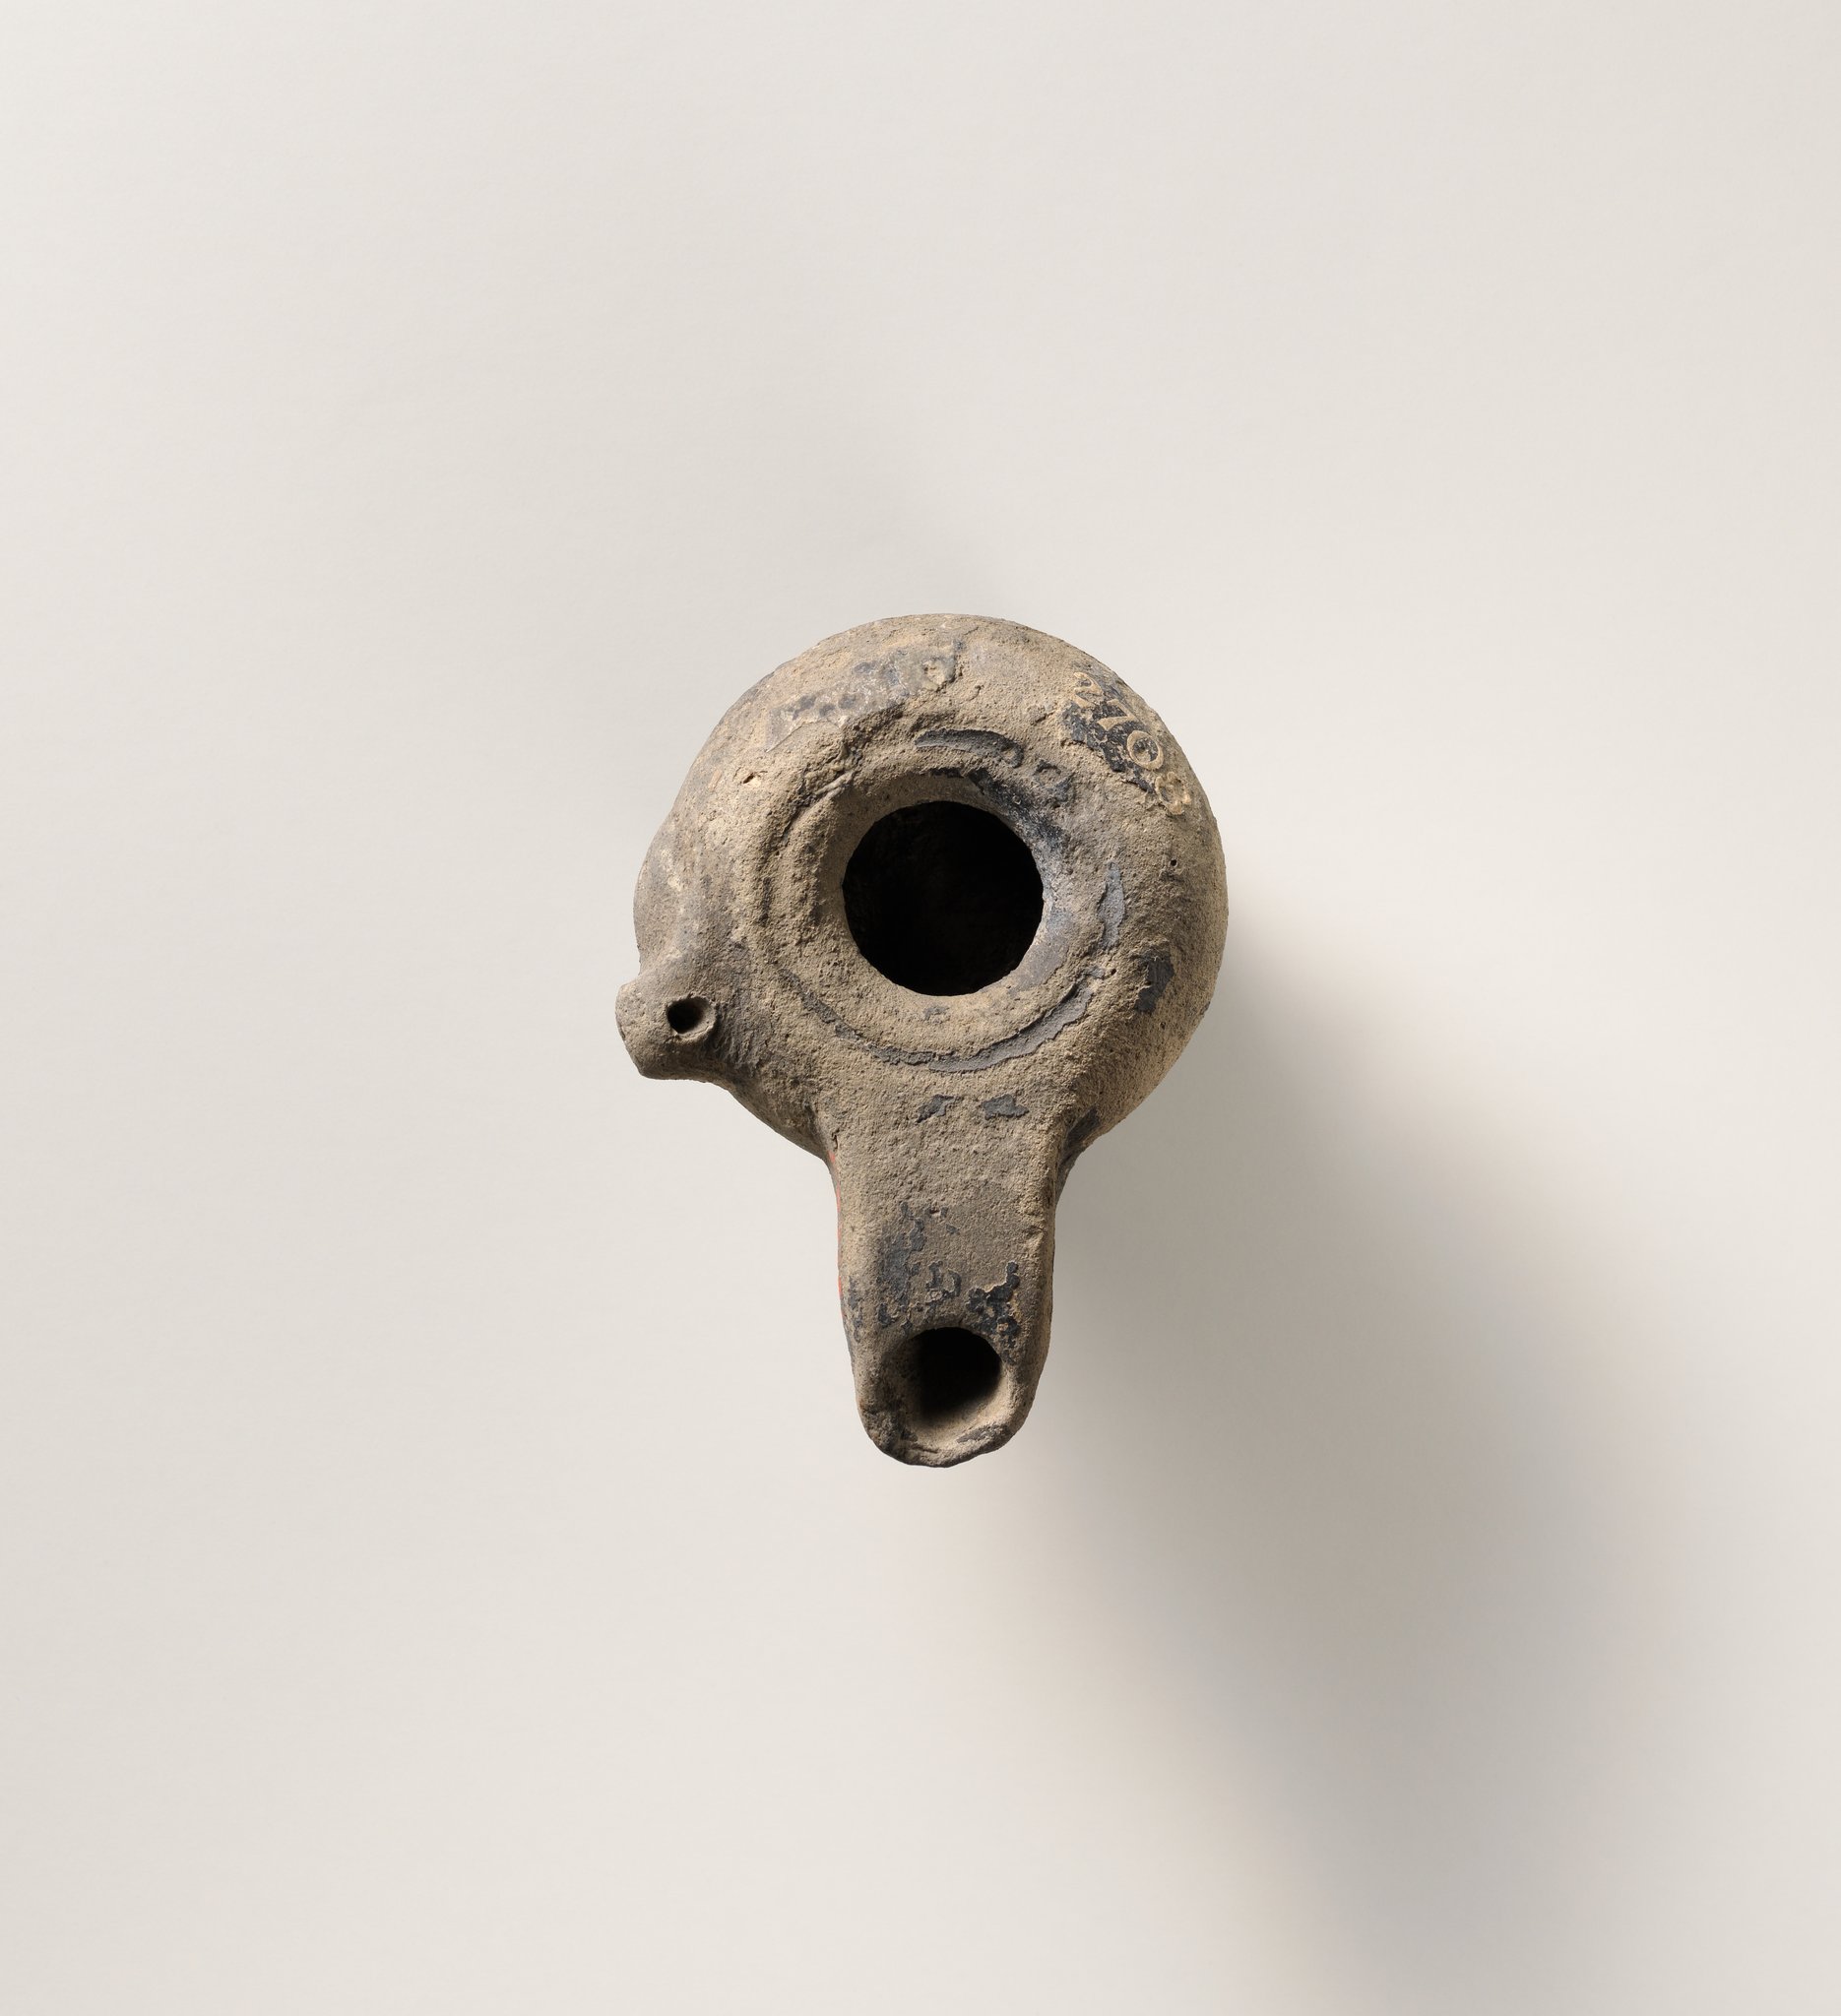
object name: lamp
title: Terracotta oil lamp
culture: greek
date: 7000 BCE-330 CE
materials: terracotta